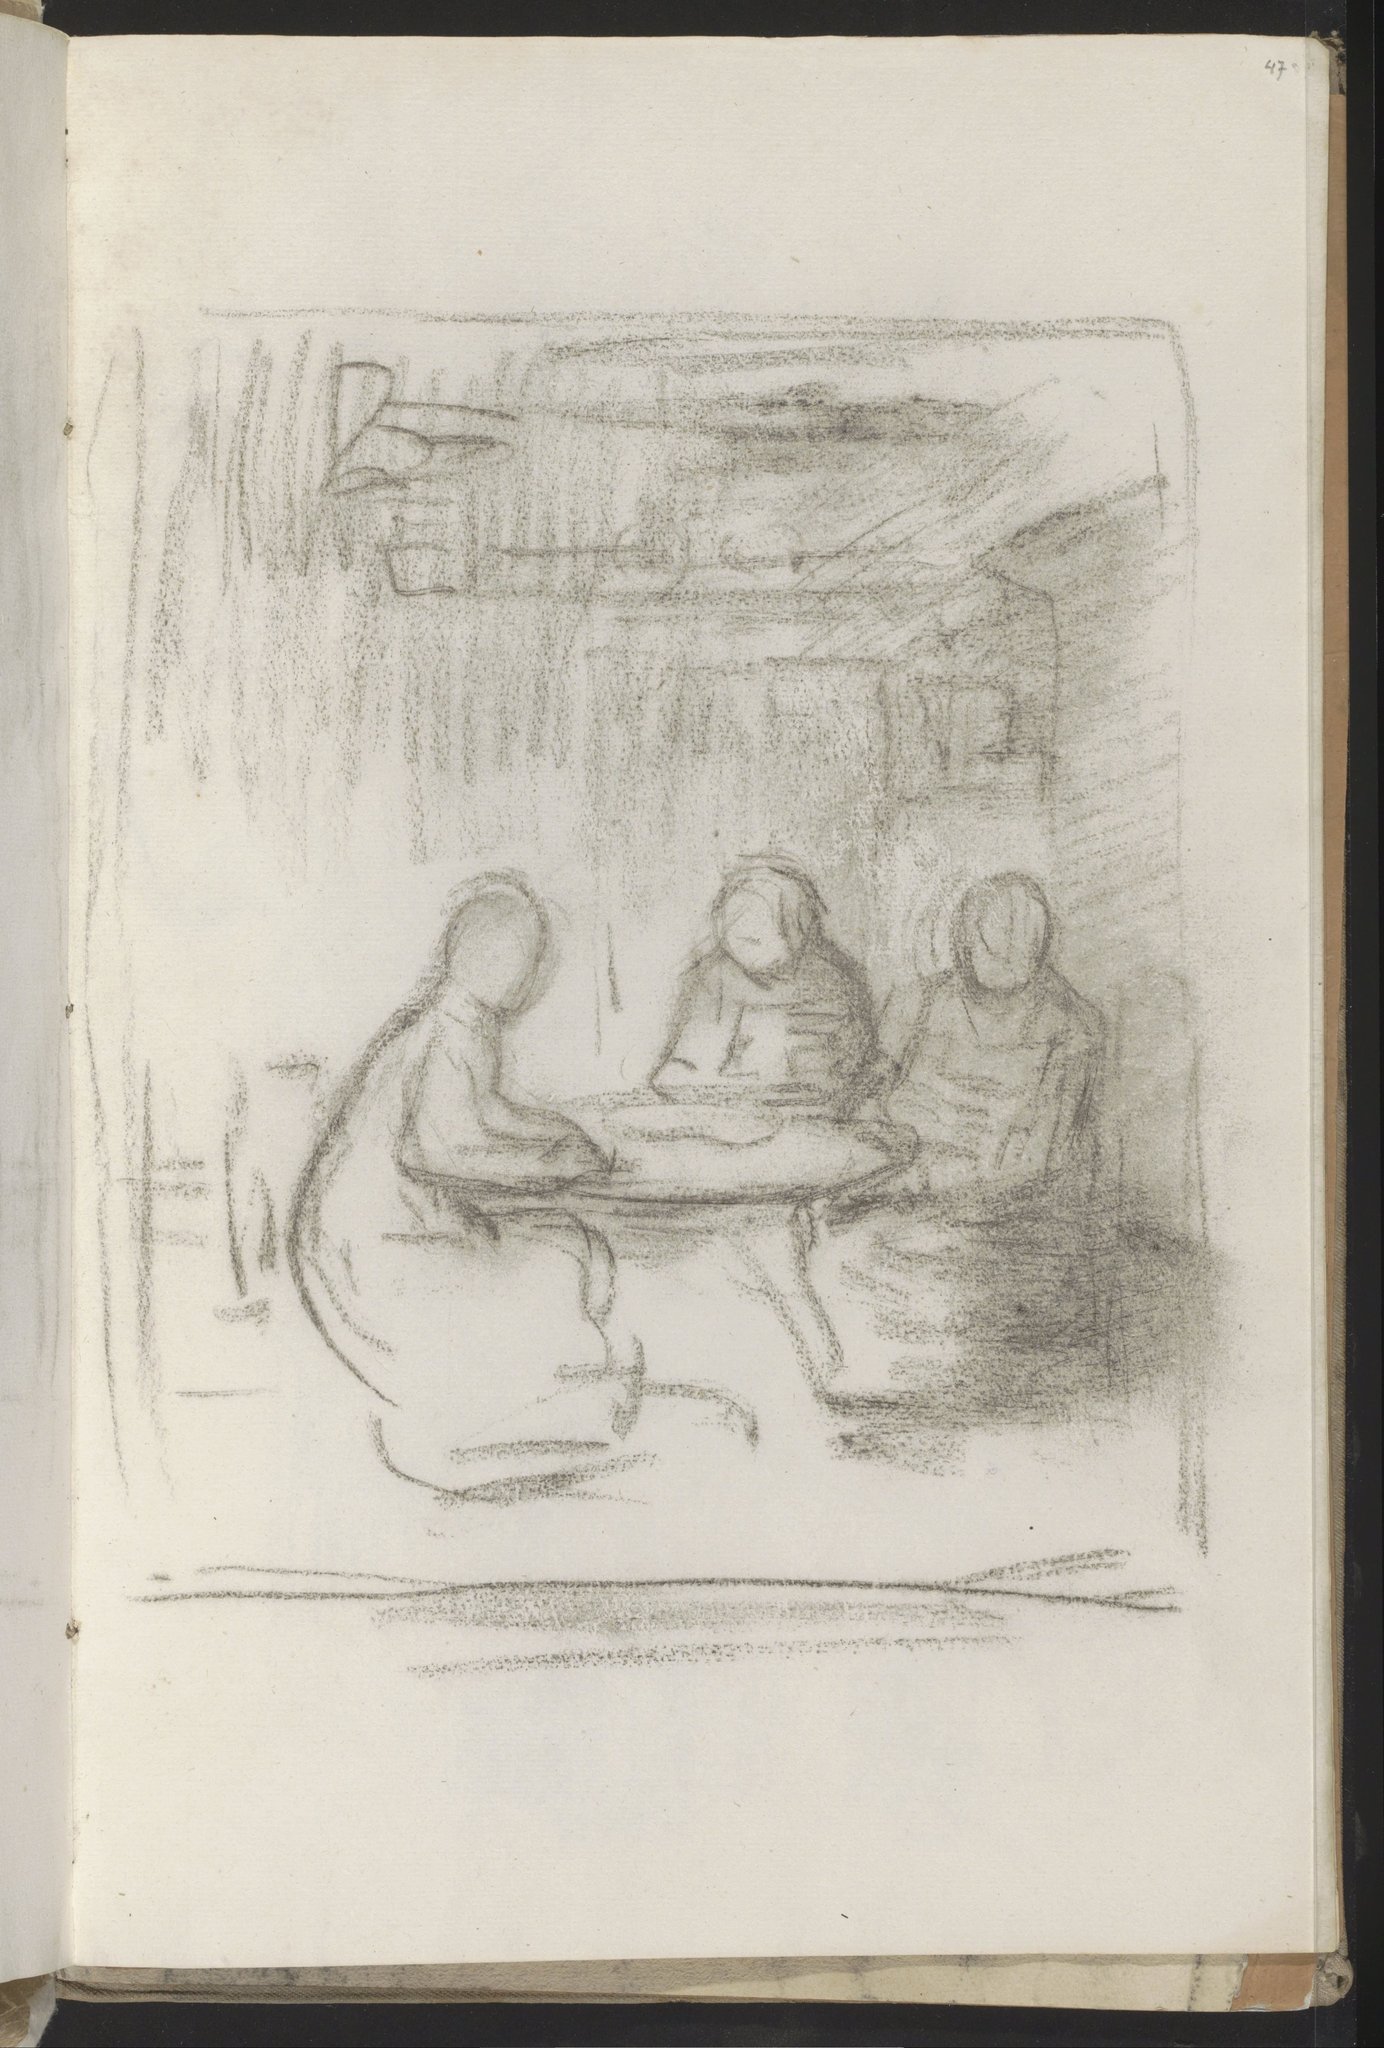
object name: sketchbook leaf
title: Interieur met drie figuren rondom een tafel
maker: albert neuhuys (1844-1914)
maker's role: draughtsman, painter, print maker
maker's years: 1844-1914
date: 1854-1914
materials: charcoal, paper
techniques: stumping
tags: sitting figure, table, interior of the house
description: Blad 47 recto uit een schetsboek met 53 bladen.